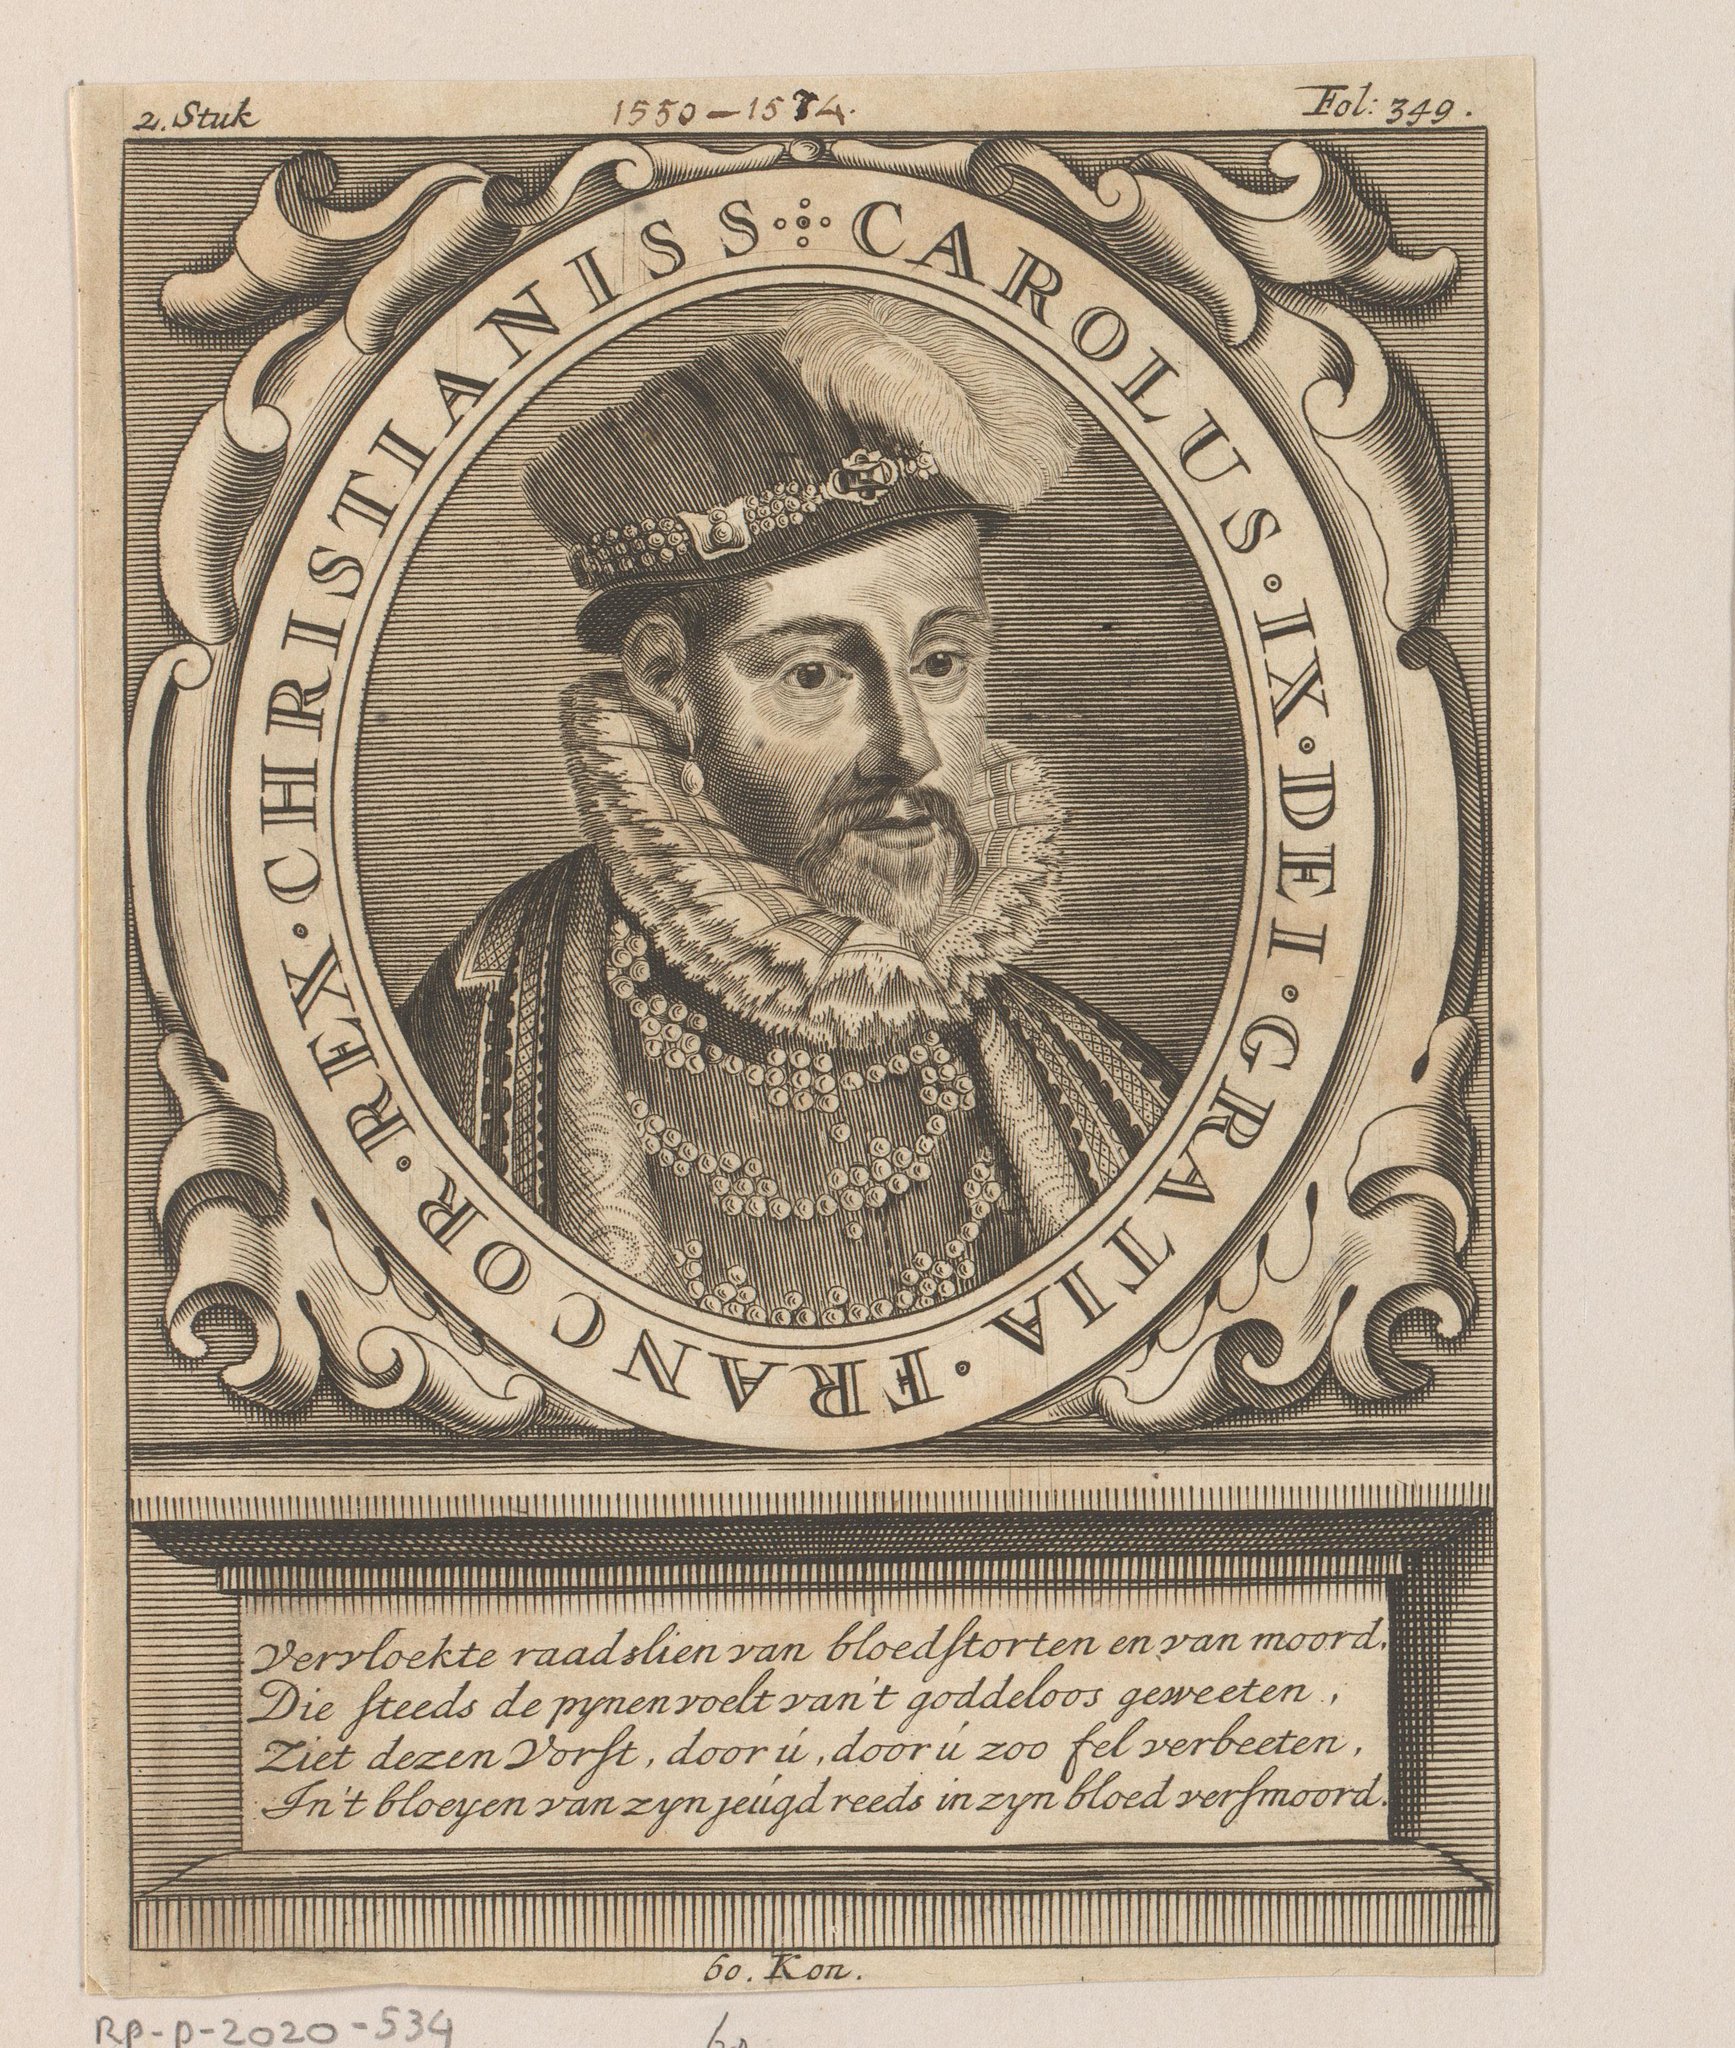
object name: print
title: Portret van Karel IX, koning van Frankrijk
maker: Anonymous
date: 1685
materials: paper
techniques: engraving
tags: karel ix (koning van frankrijk), historical persons, king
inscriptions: inscription: ‘1550-1574.’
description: Prent gebruikt in: Eudes de Mézeray, François. Chronyk van Vrankryk. 6 dln. Amsterdam: Jan Bouman en Timotheum ten Hoorn, 1685, dl. 5.